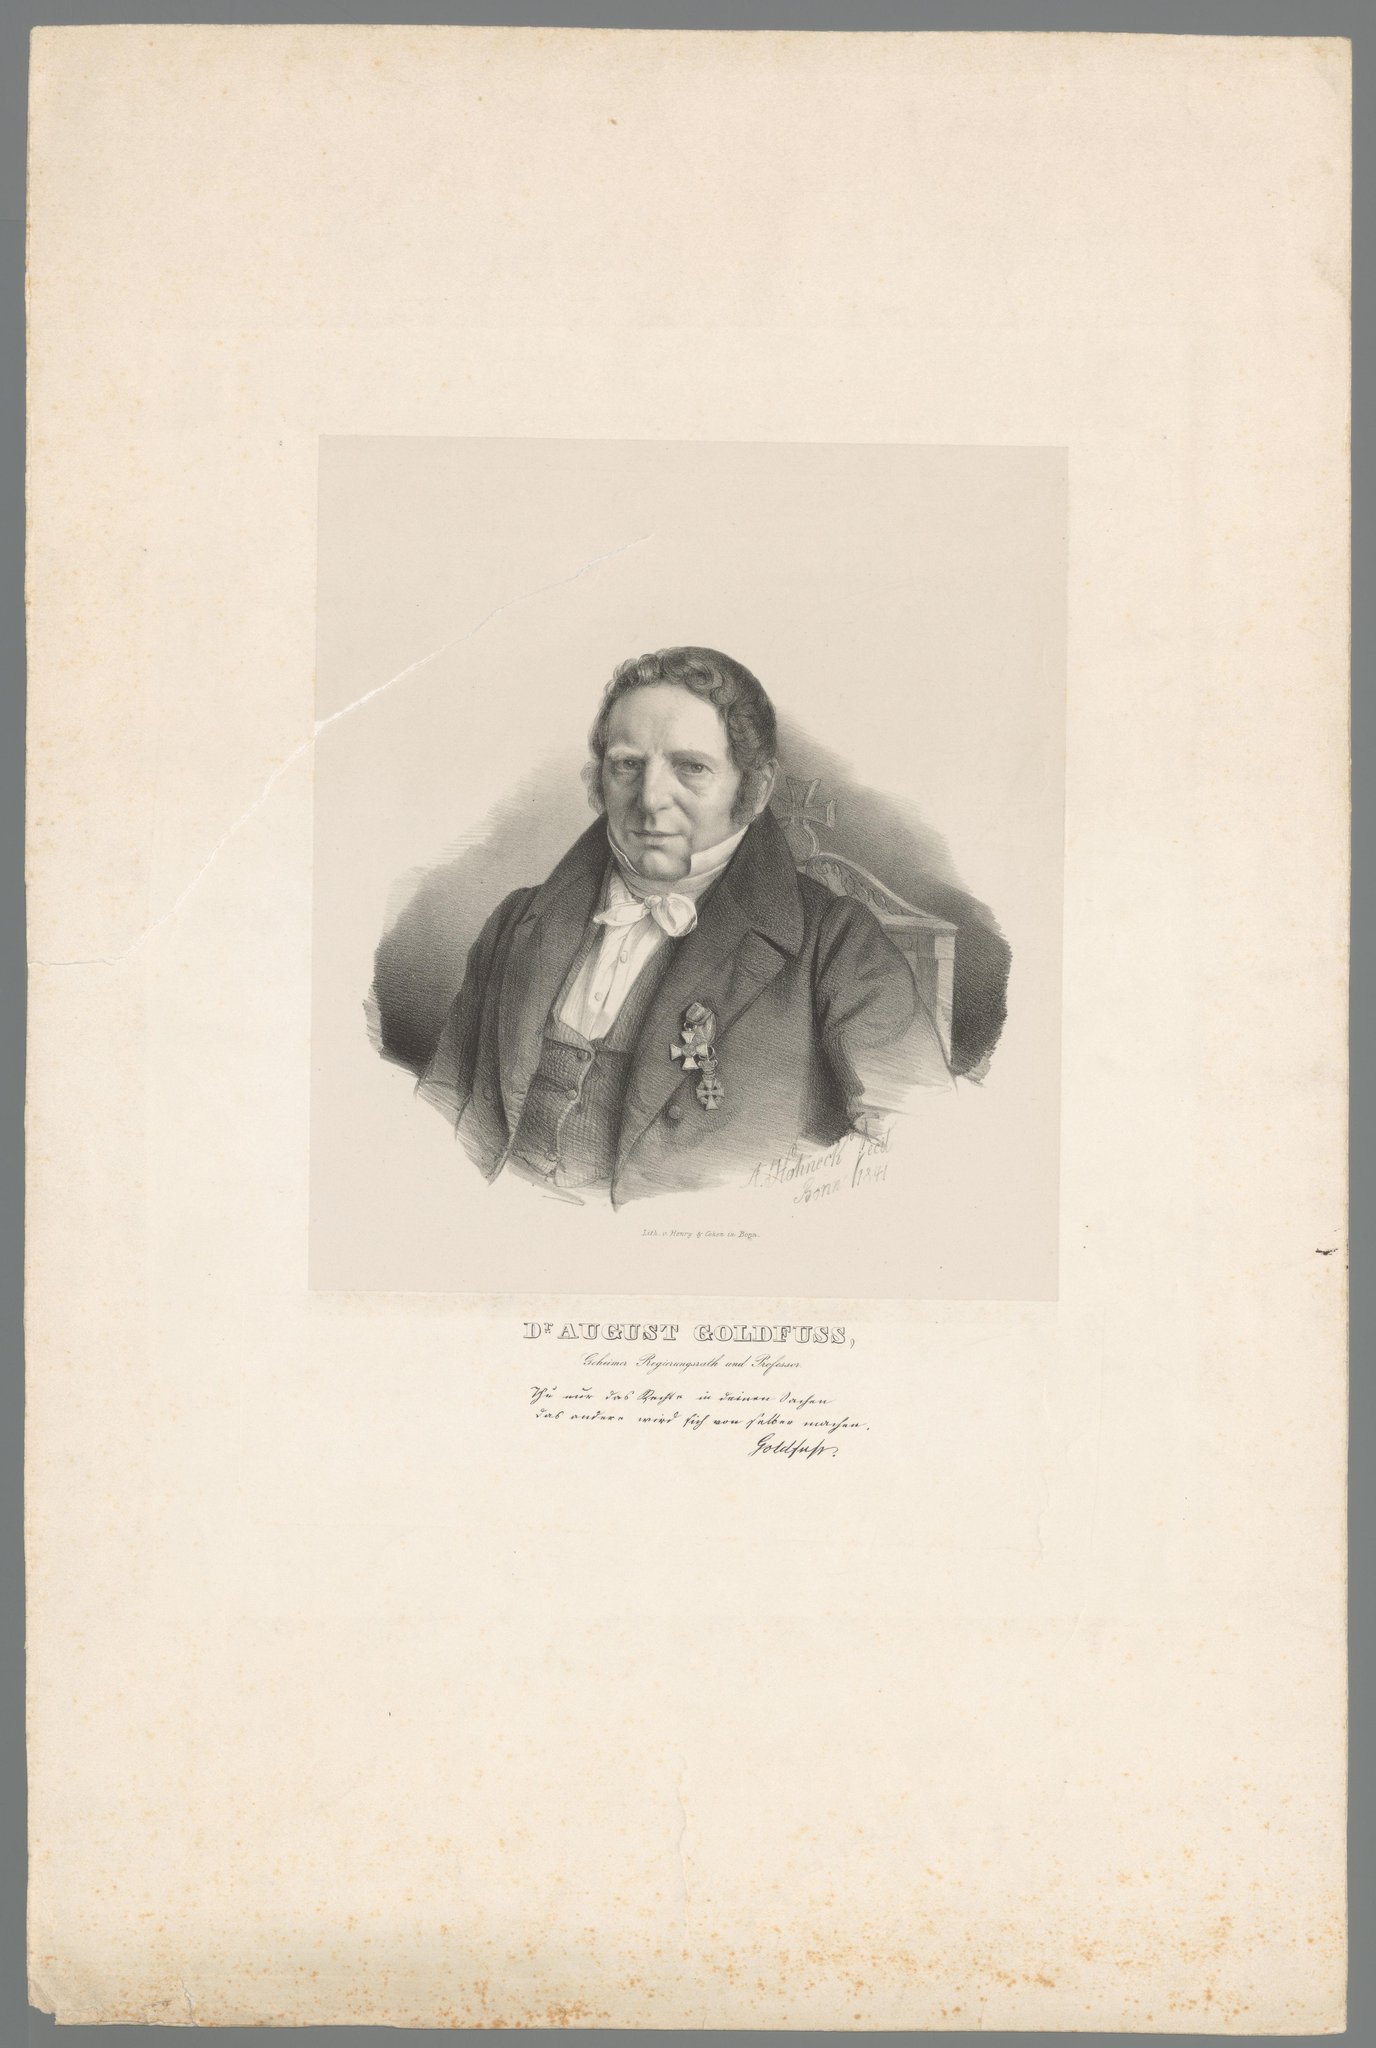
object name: print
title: Portret van Georg August Goldfuss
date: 1841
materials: paper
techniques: lithograph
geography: bonn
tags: georg august goldfuss, adult man, historical persons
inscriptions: collector's mark: Lugt 2228